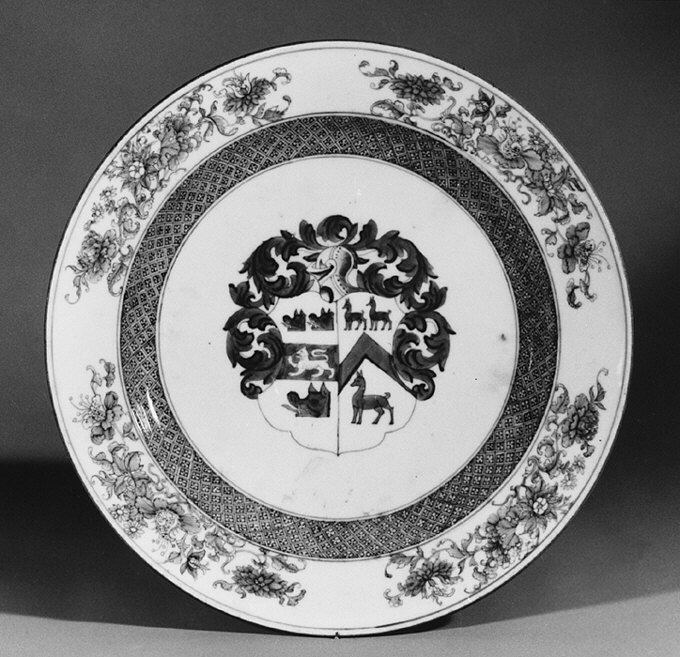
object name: plate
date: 1725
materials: hard paste porcelain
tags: flowers,coat of arms